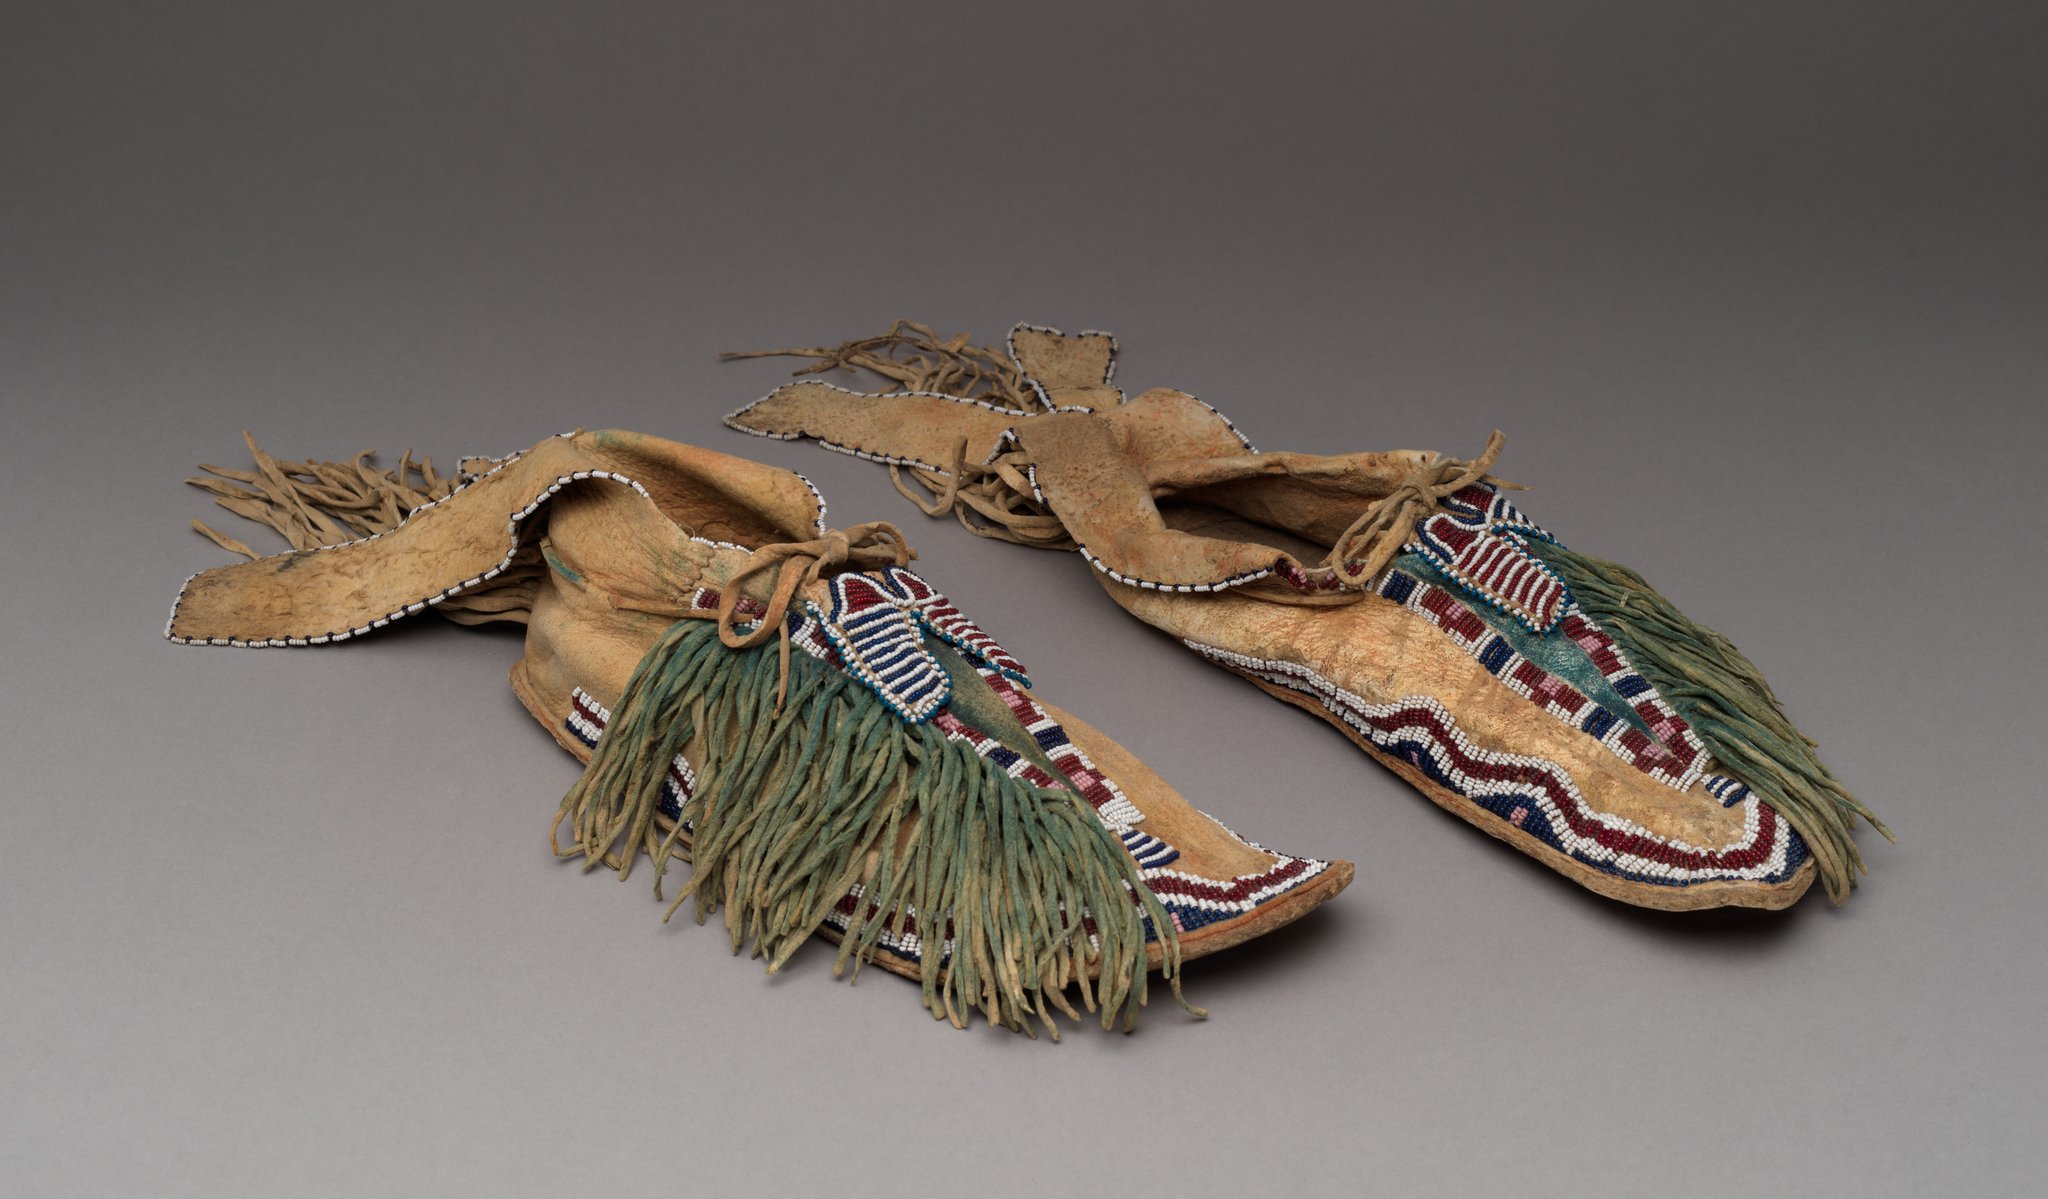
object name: man's moccasin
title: Man's moccasins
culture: comanche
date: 1870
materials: glass, leather, pigment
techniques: tanning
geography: united states